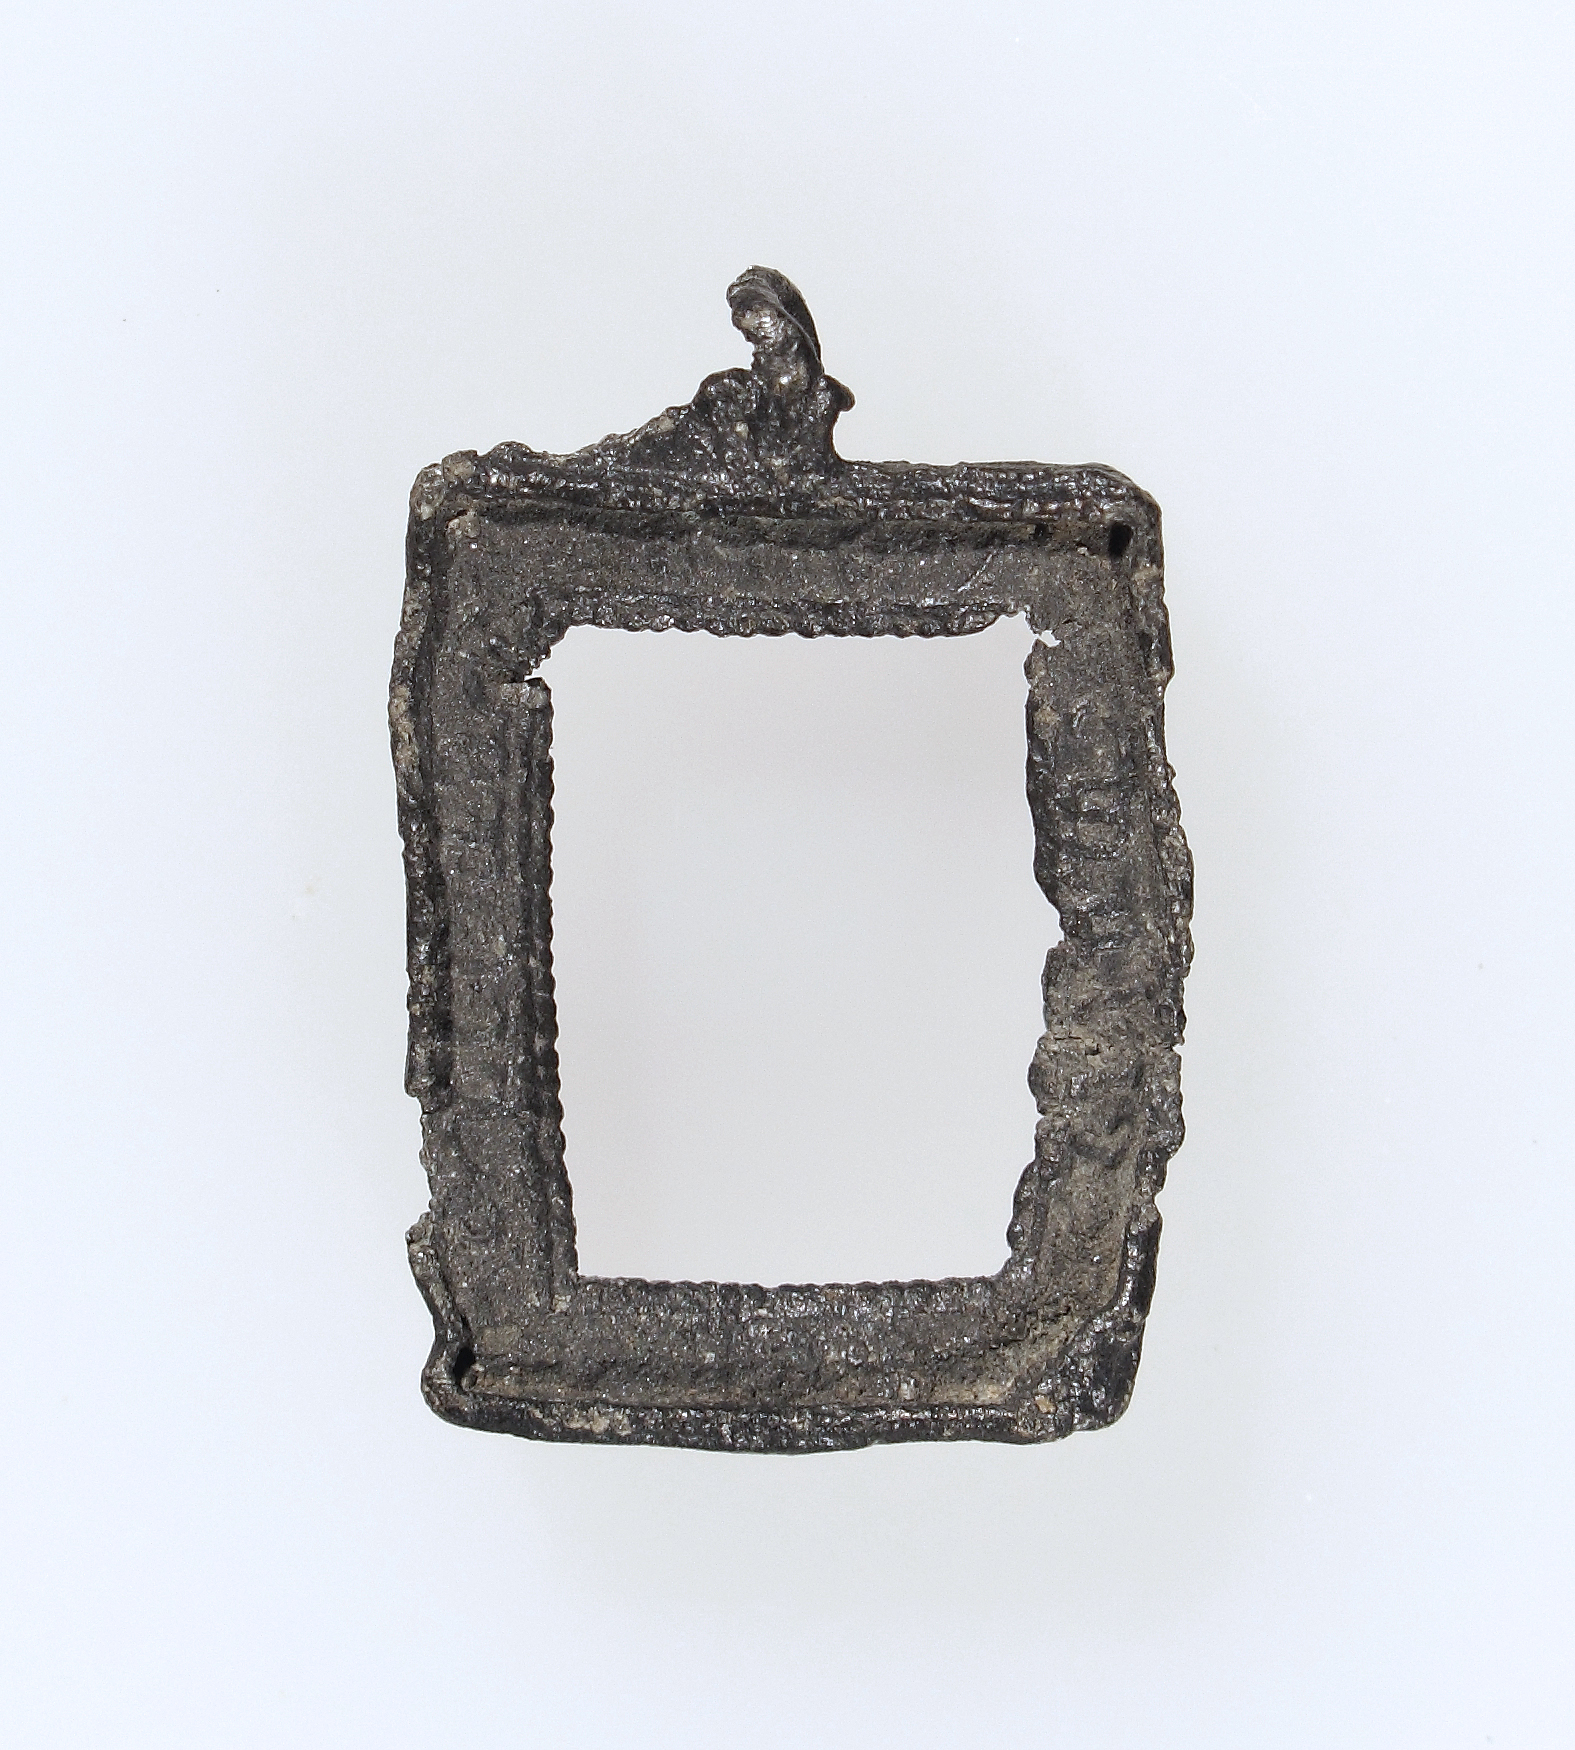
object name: pilgrim's badge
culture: french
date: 1301-1600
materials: lead